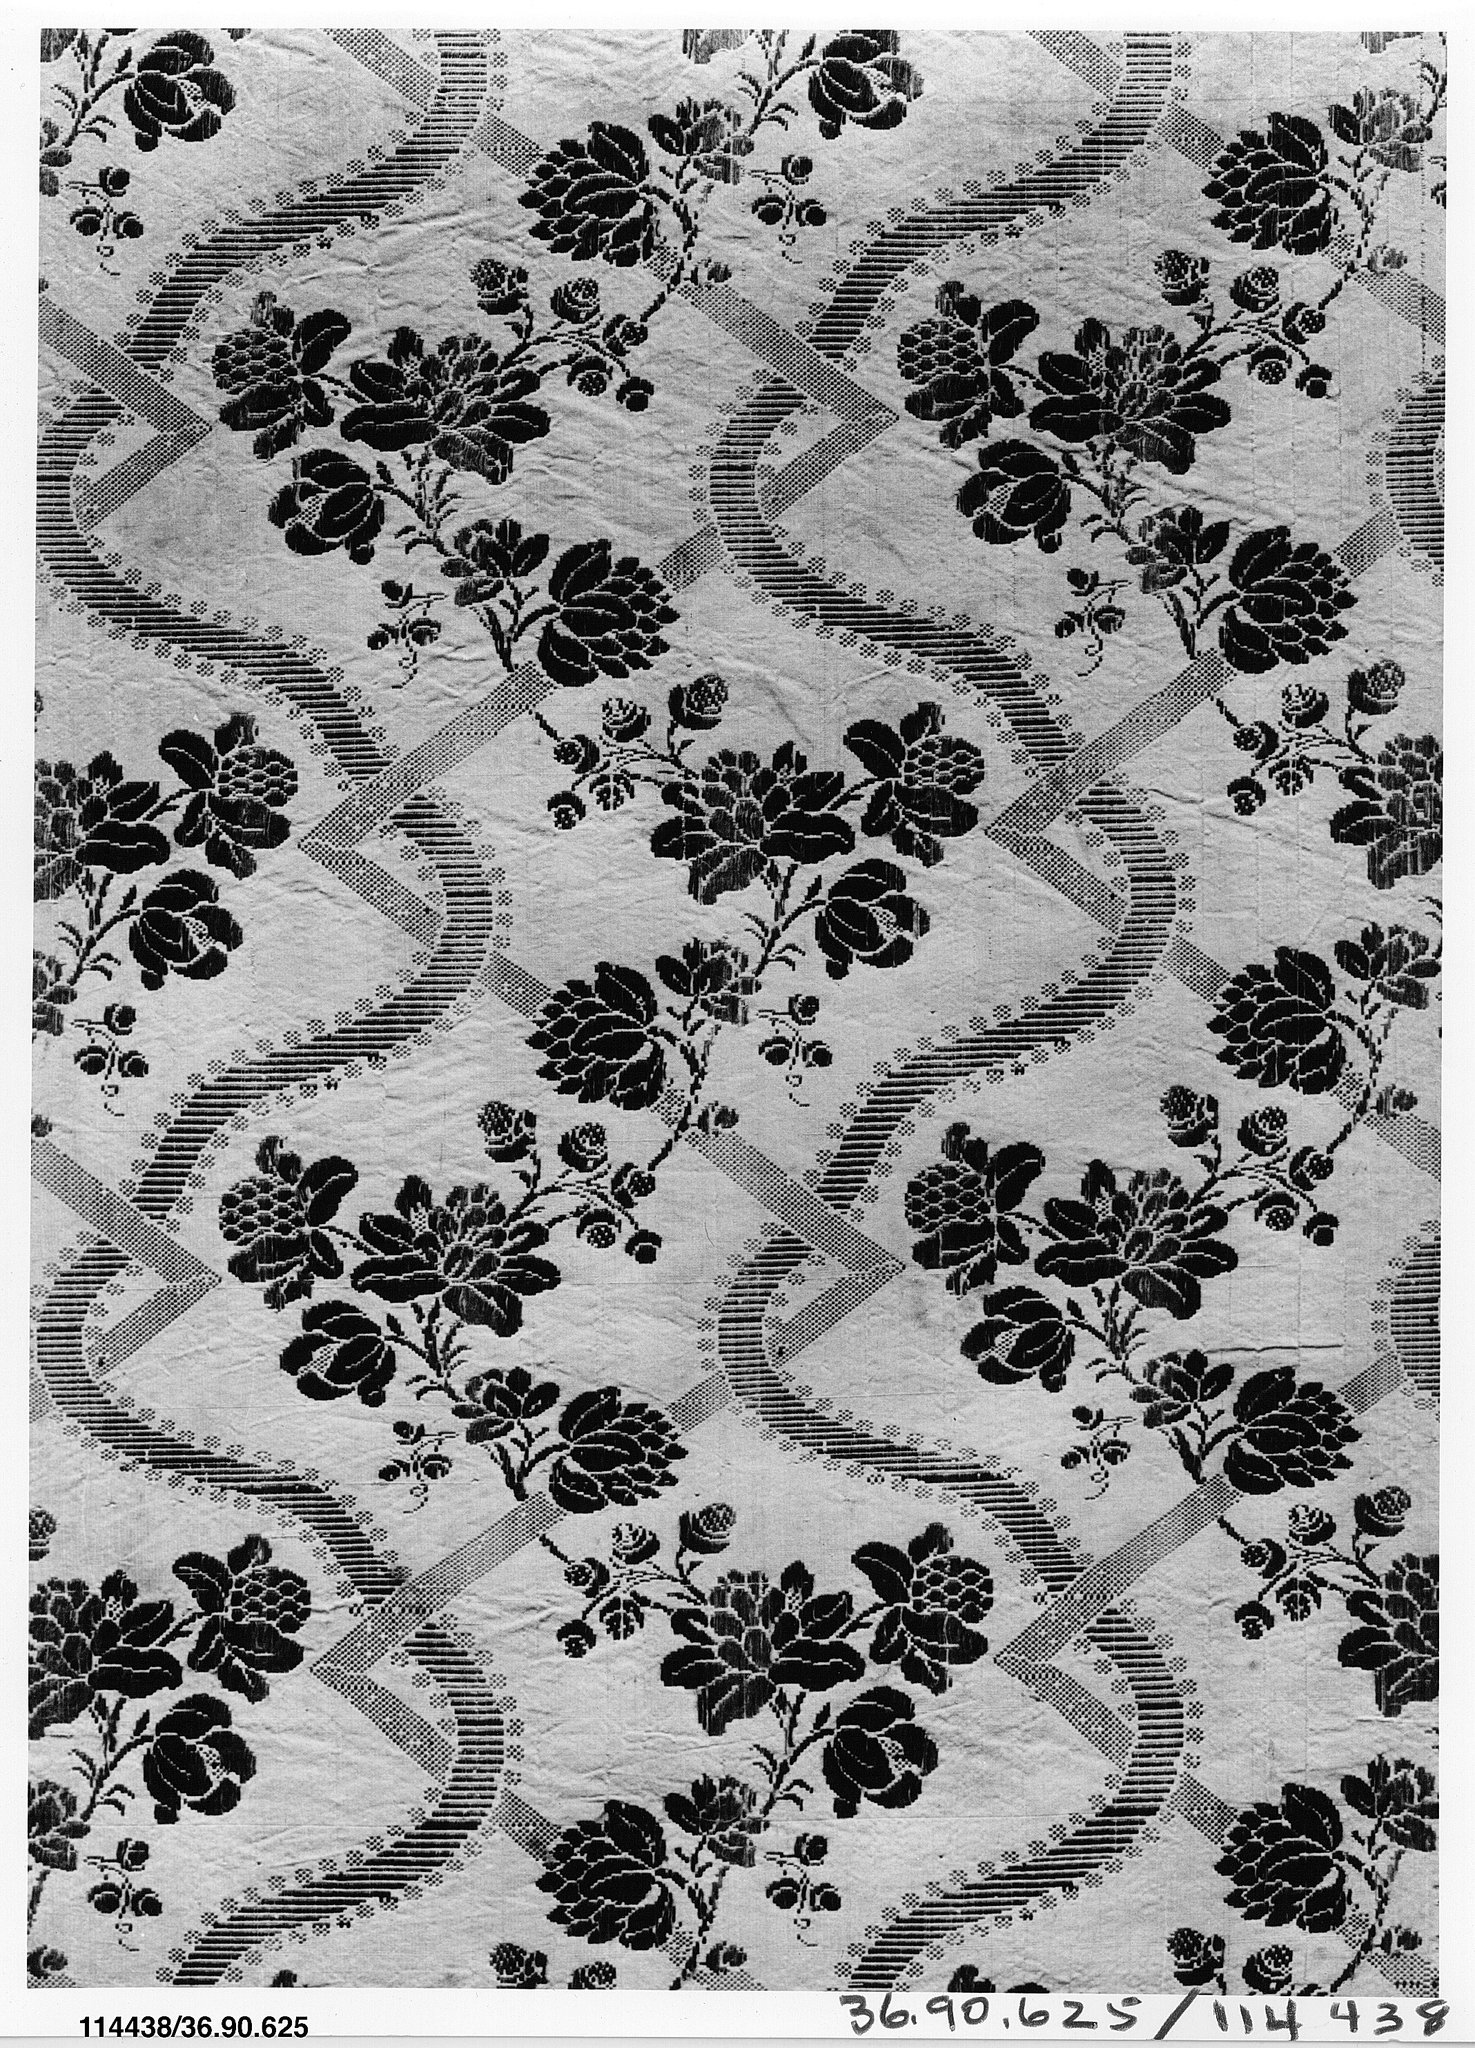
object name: piece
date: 1750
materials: silk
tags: flowers